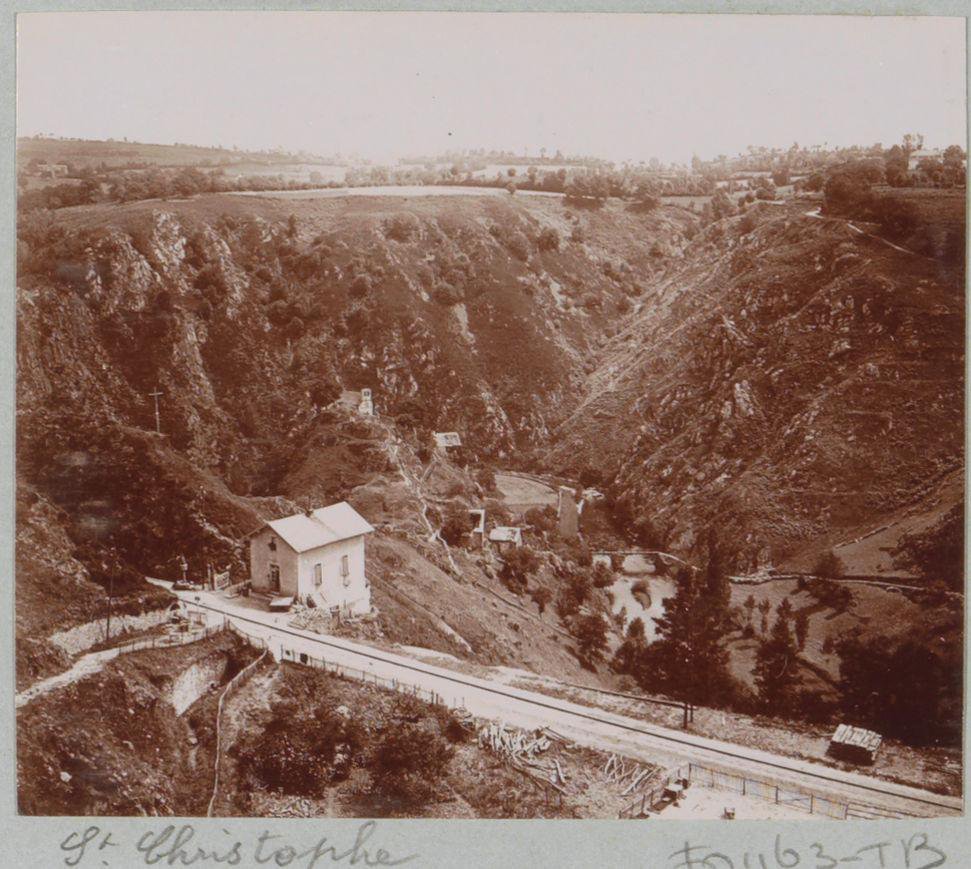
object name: photograph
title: Gezicht op Saint-Christophe in Frankrijk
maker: delizy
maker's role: manufacturer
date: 1903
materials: paper, photographic support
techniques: gelatin silver print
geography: france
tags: prospect of village, silhouette of village, france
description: Onderdeel van Fotoalbum van een Franse amateurfotograaf met opnames van uitstapjes in Frankrijk, Spanje, België, Luxemburg en Nederland, de eerste automobielen en autoraces.